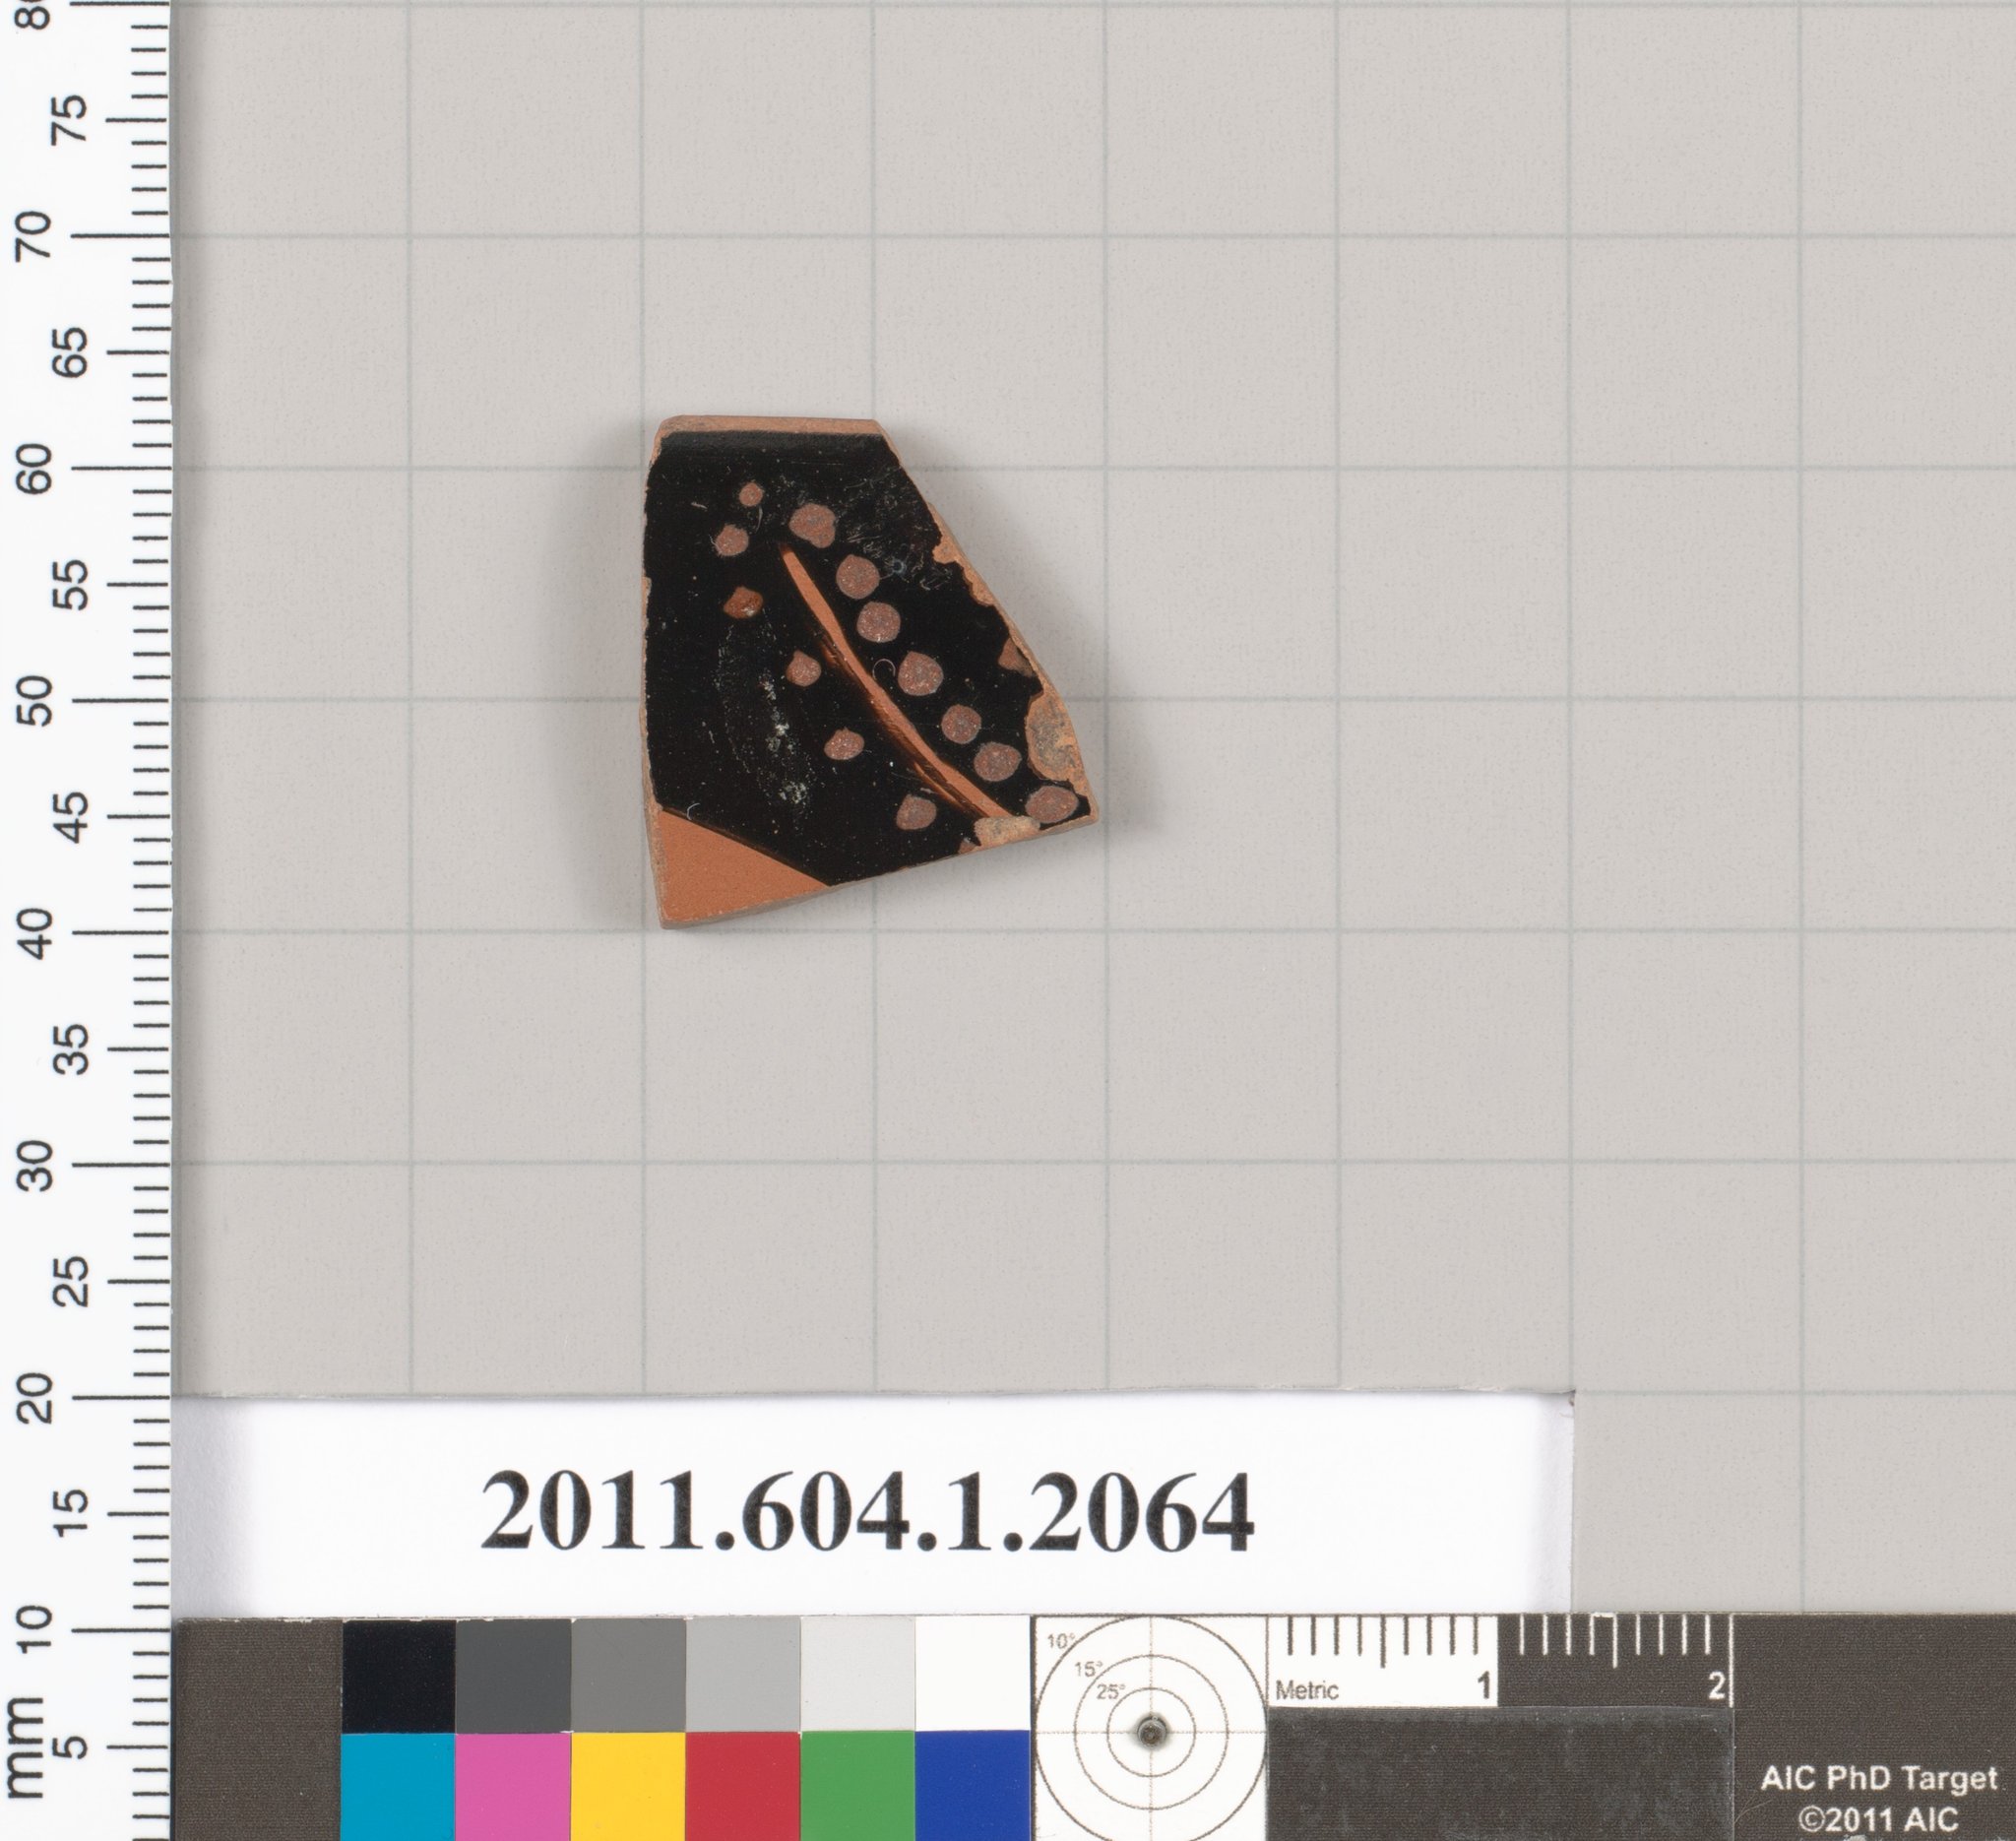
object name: kylix fragment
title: Terracotta rim fragment of a kylix (drinking cup)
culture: greek, attic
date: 475-451 BCE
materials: terracotta